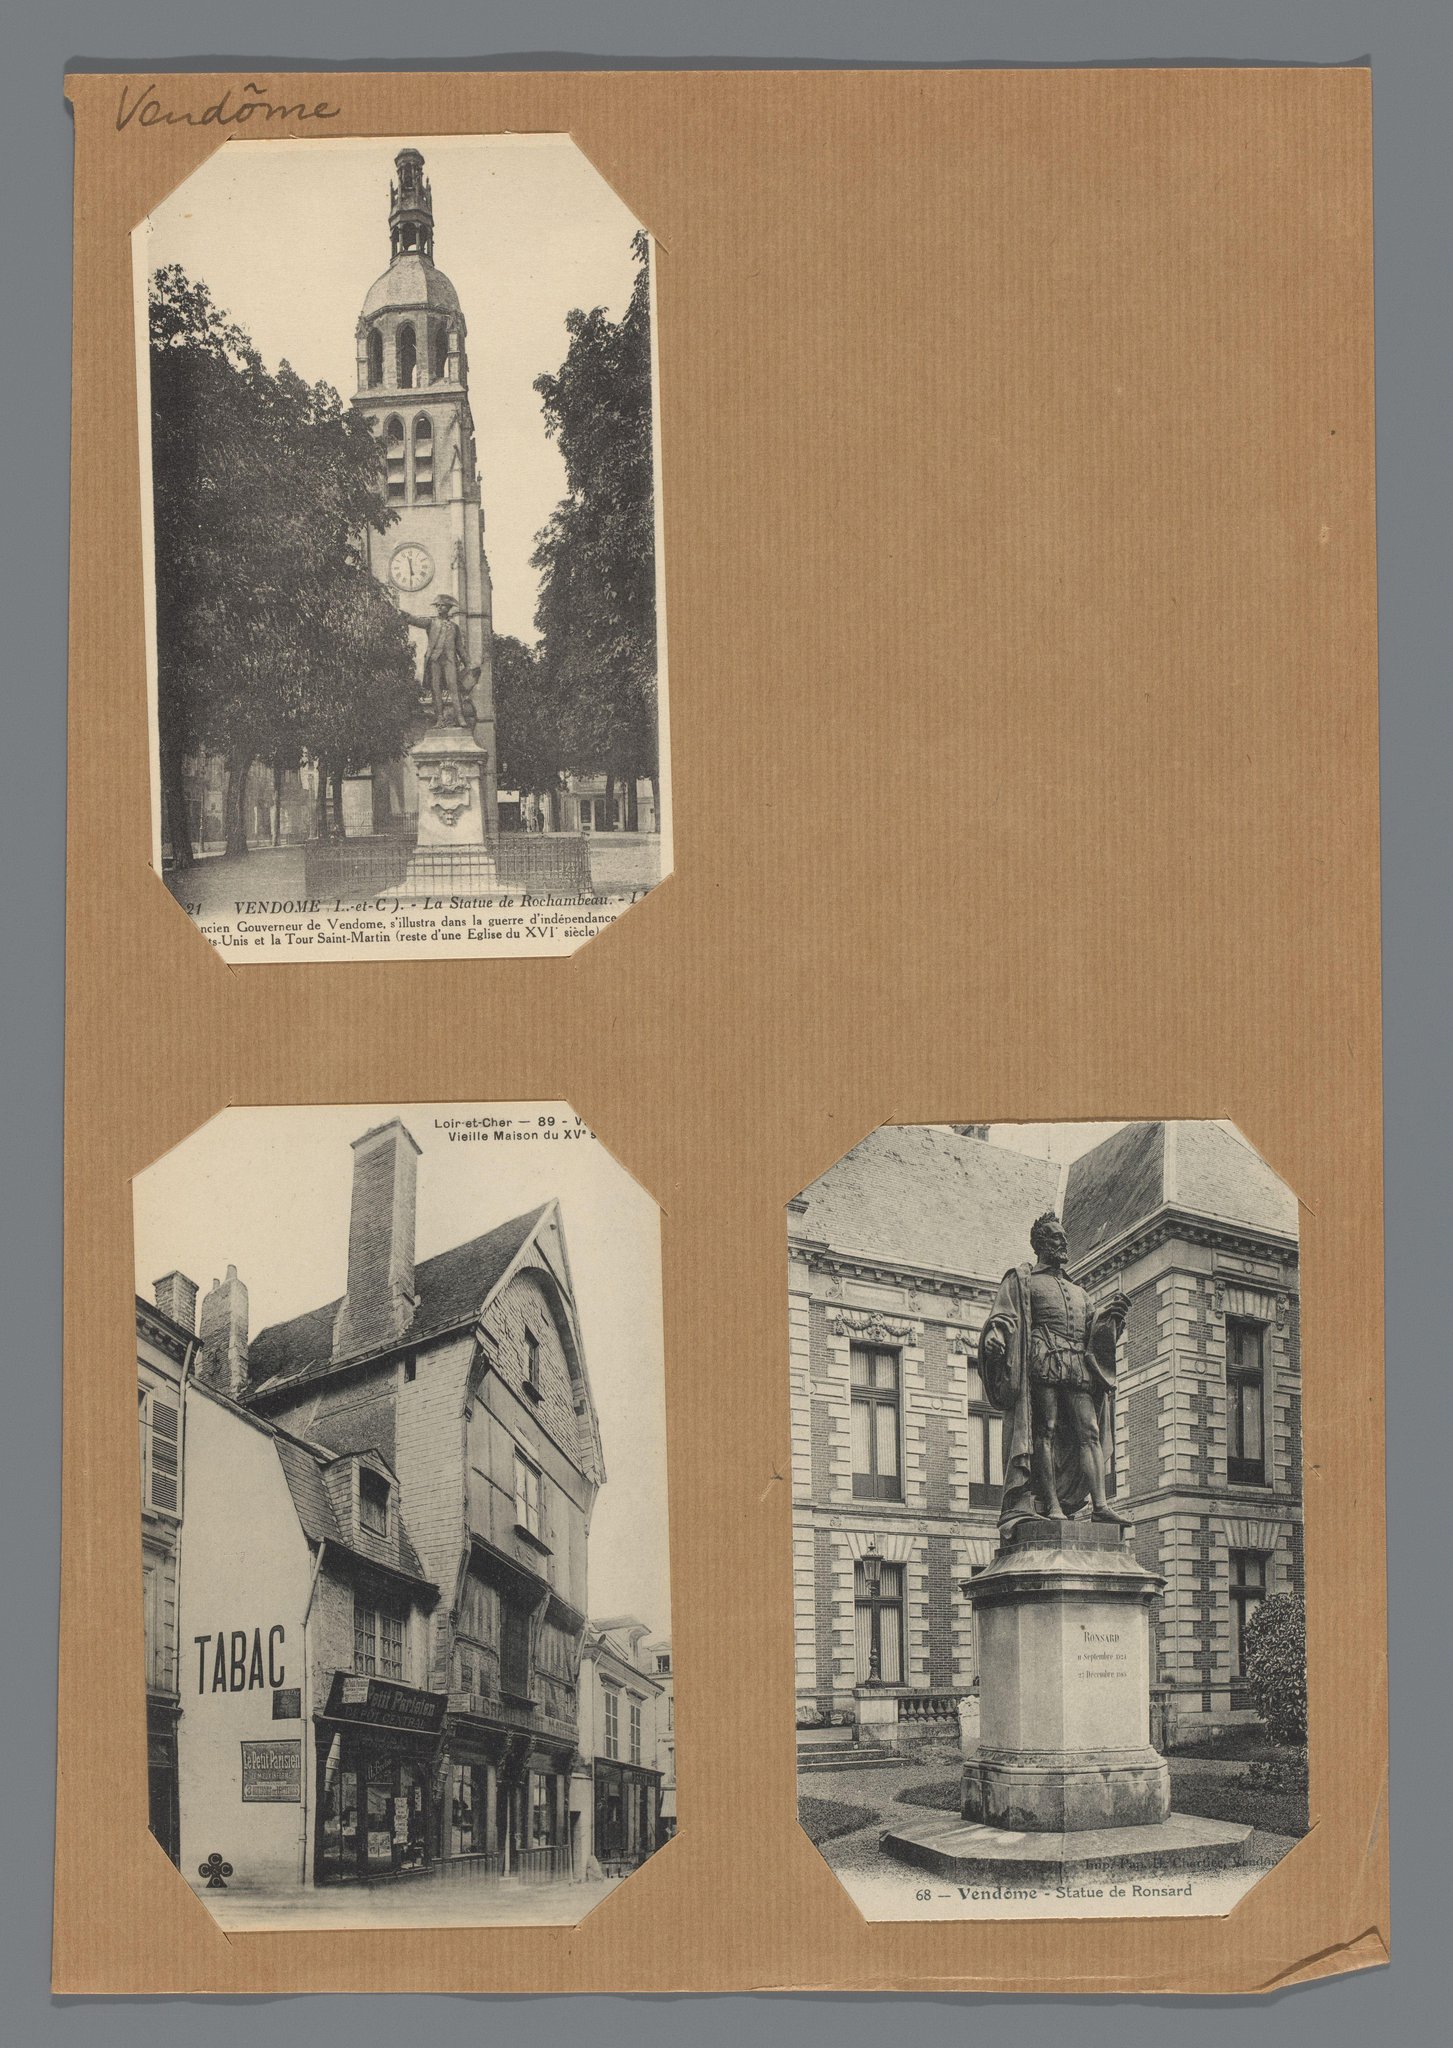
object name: photograph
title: Vendôme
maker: Anonymous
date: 1860-1925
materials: paper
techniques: photograph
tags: vendôme